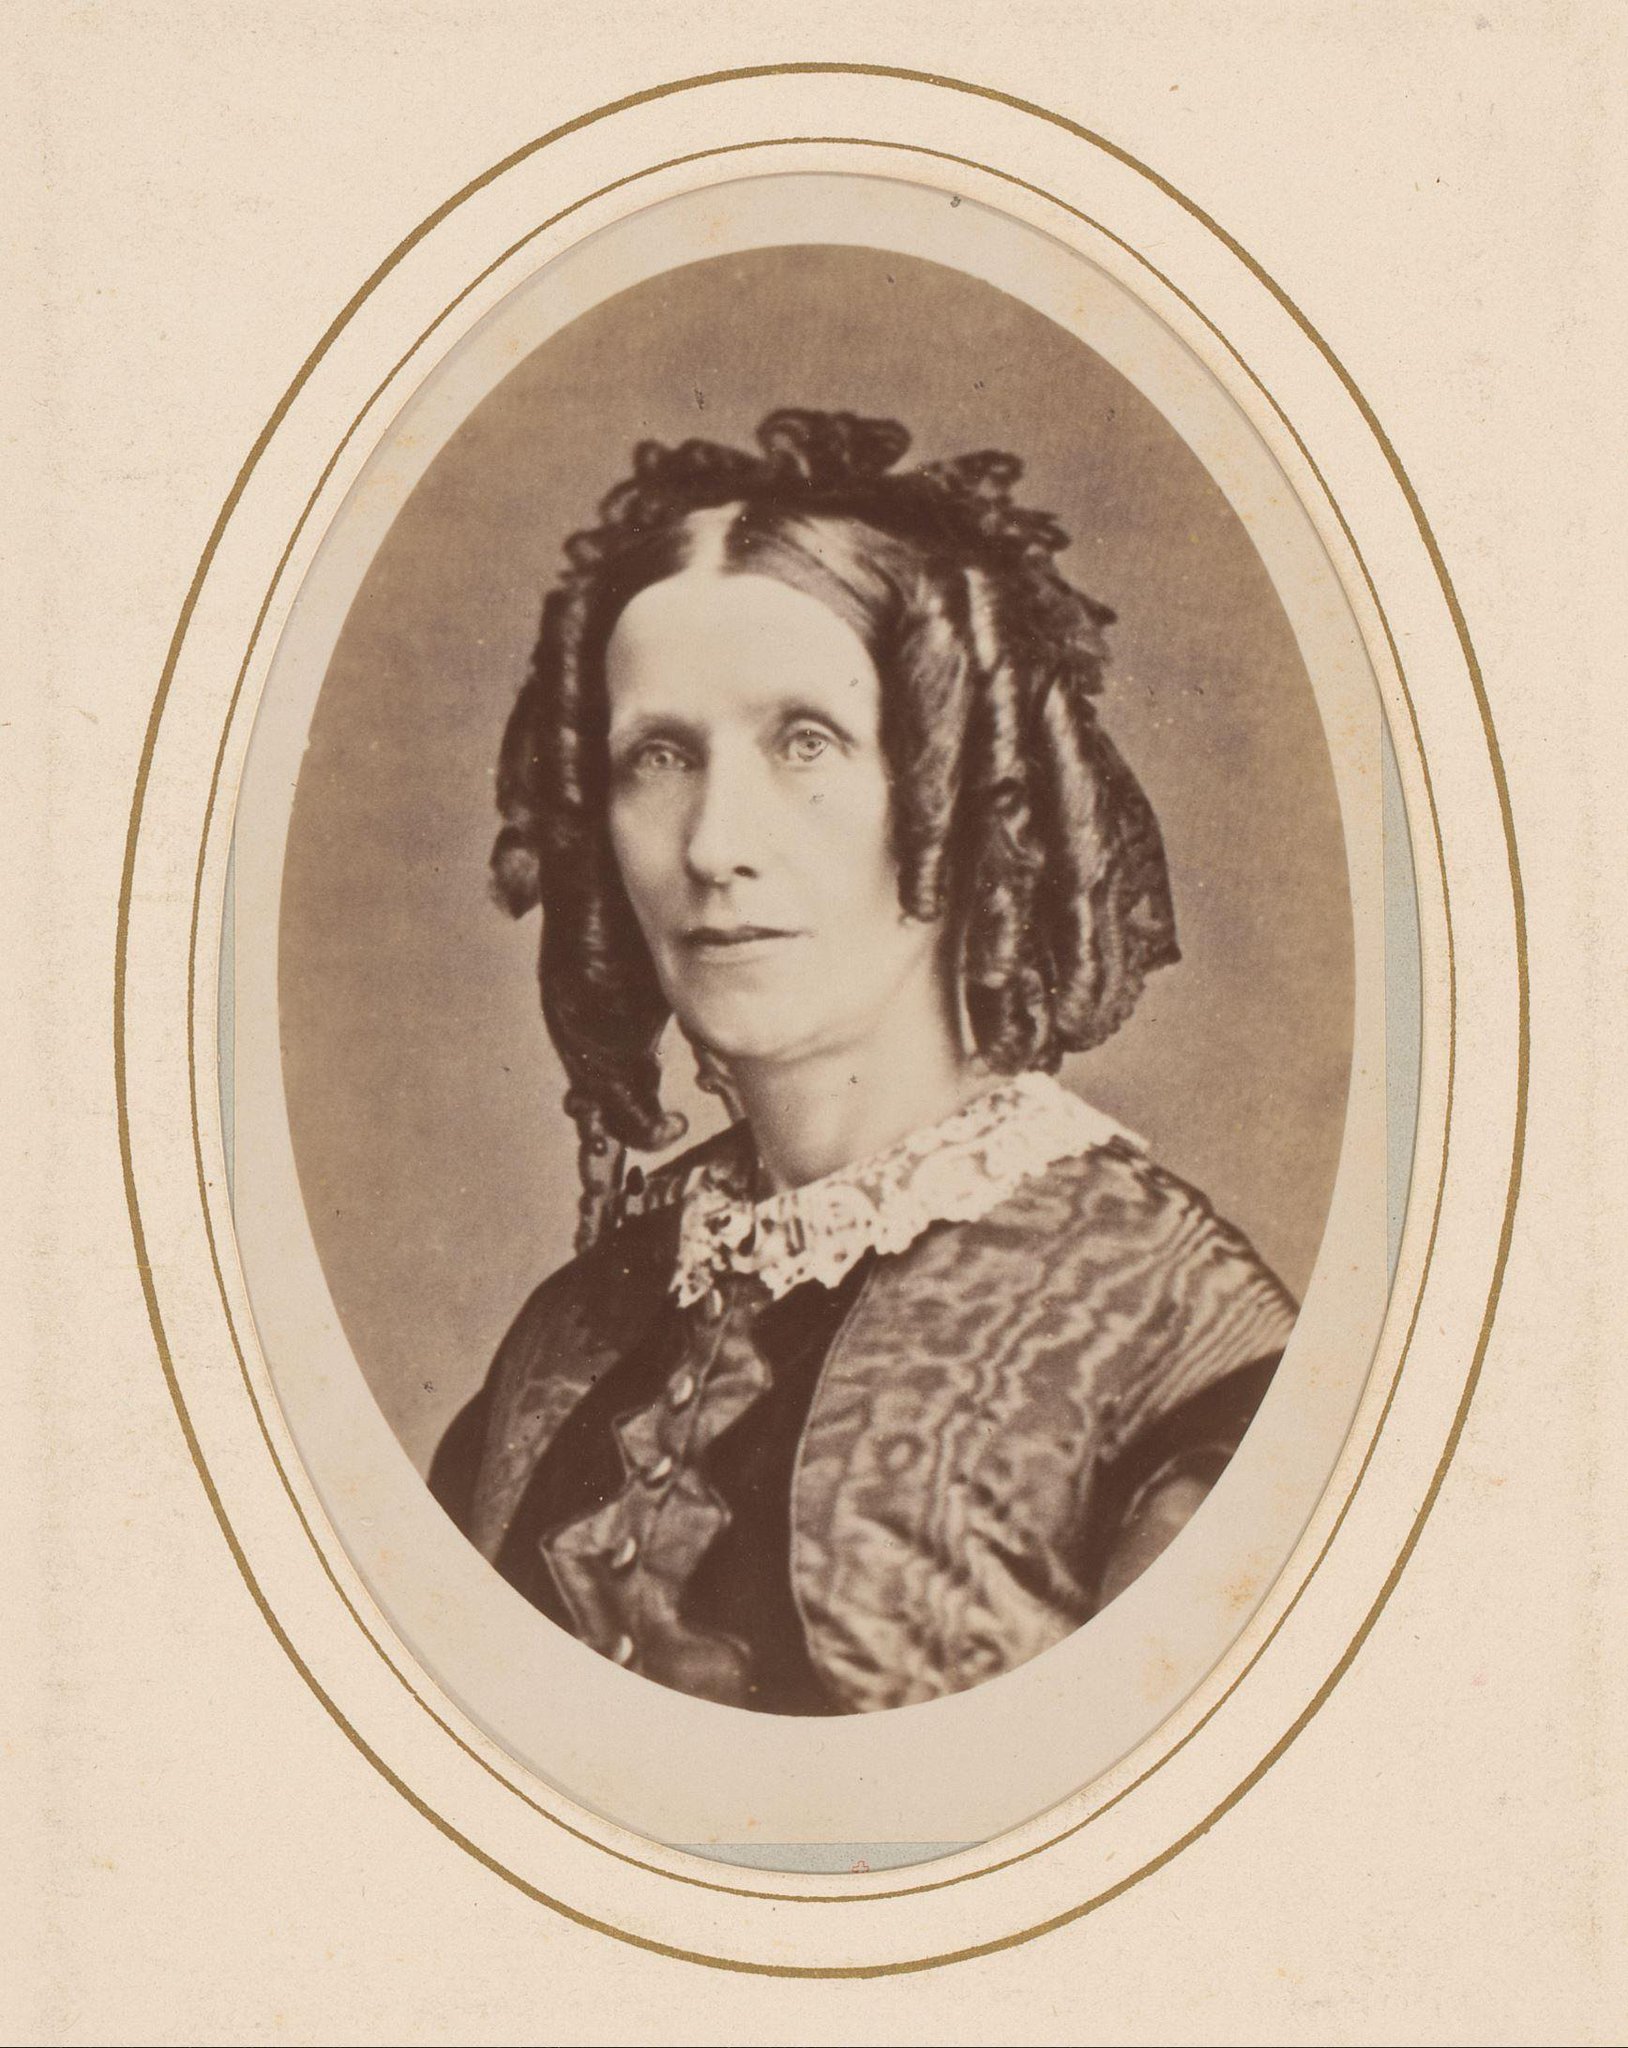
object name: photograph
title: Portret van een vrouw met pijpenkrullen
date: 1860-1894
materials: cardboard, photographic support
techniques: albumen print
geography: brussels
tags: historical persons - bb - woman, hairdress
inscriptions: inscription: ‘GHÉMAR FRÈRES/ Photographes du Roi/ (MÉDAILLES D'OR)/ 27, Rue de l'Ecuyer, 27./ Entrée par la porte cochère/ BRUXELLES/ Les Clichés sont conservés indéfiniment’